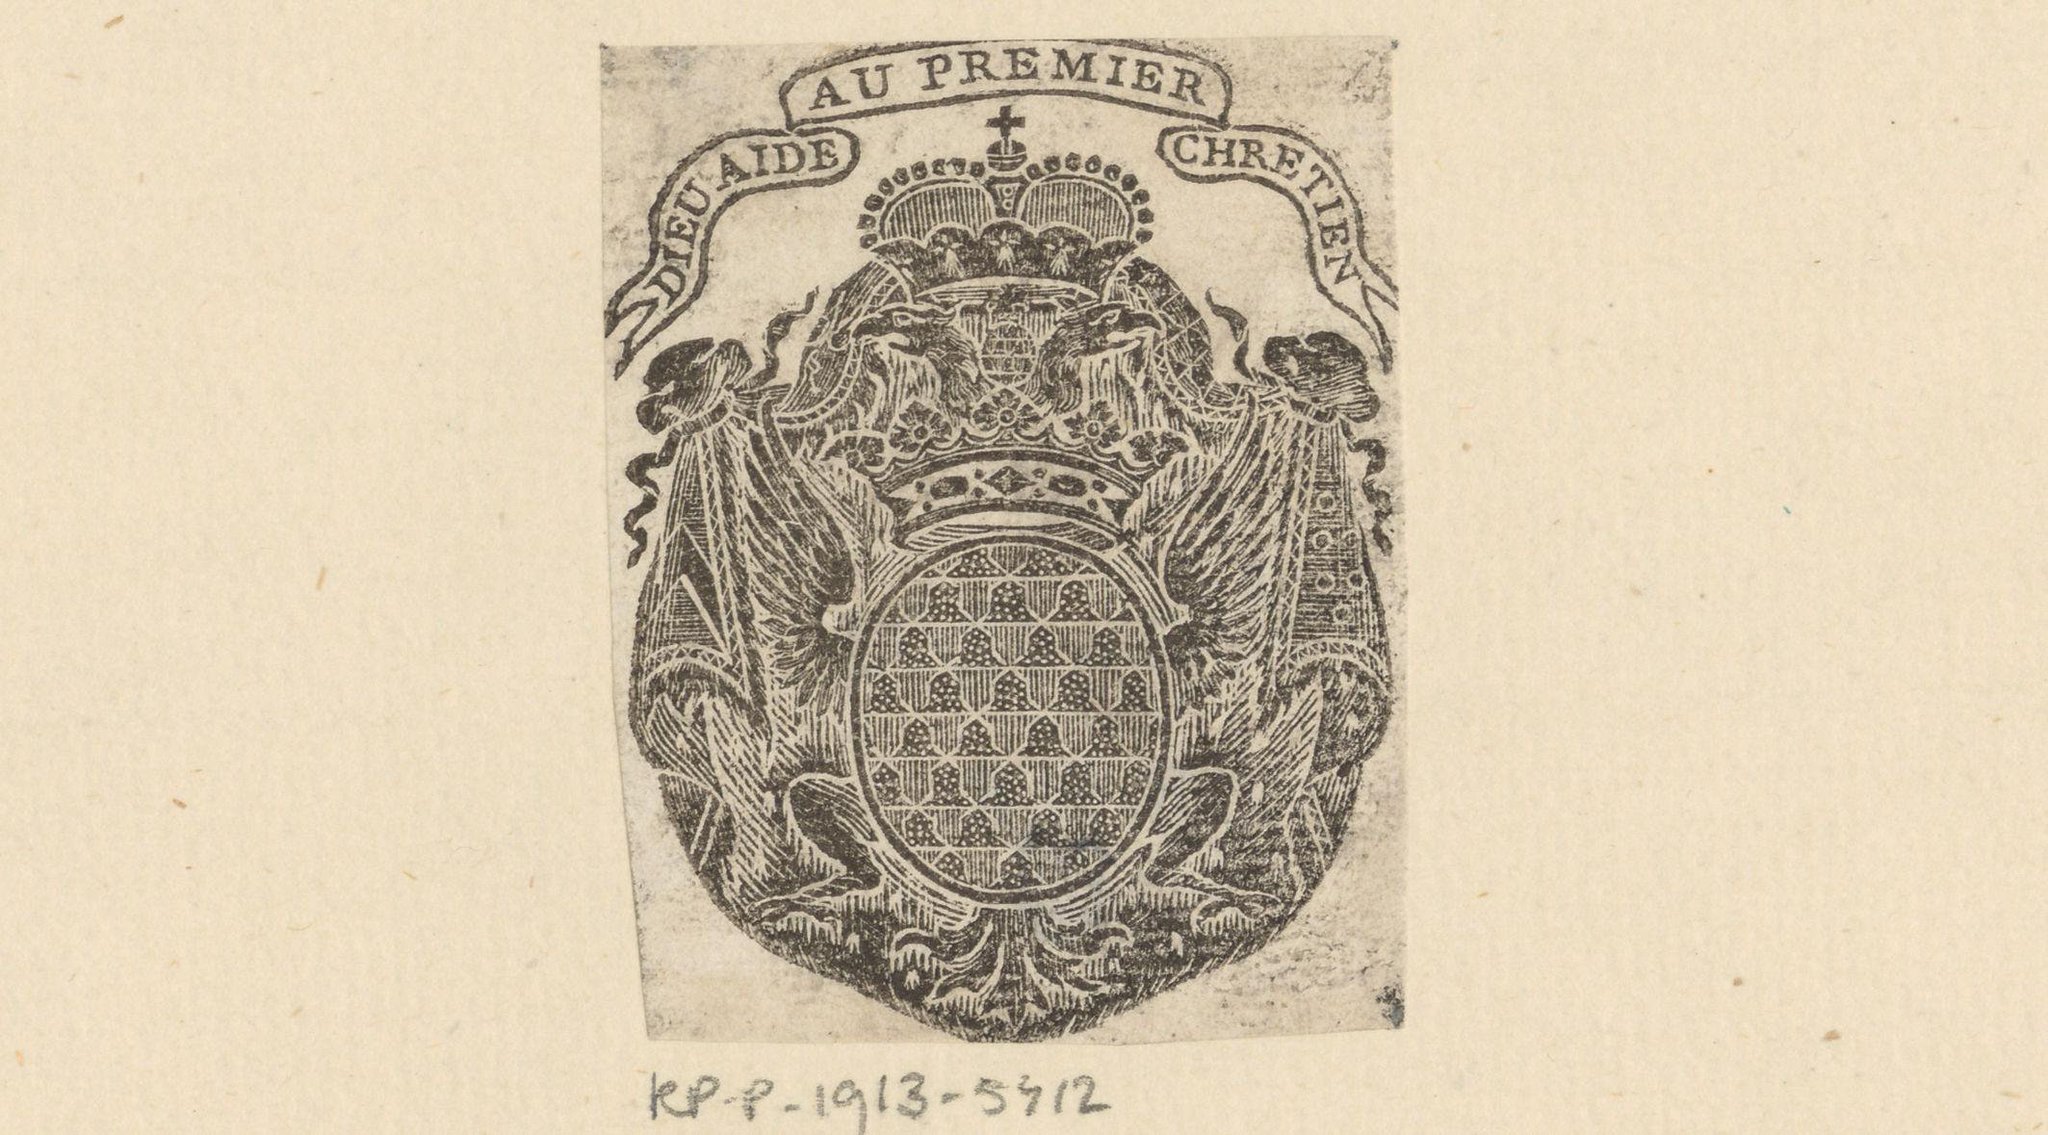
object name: bookplate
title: Ex libris van Alexandre de Bauffremont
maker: Anonymous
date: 1783-1833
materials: paper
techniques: engraving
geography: france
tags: double-headed eagle, armorial bearing, heraldry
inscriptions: collector's mark: Lugt 2233, collector's mark: Lugt 2760